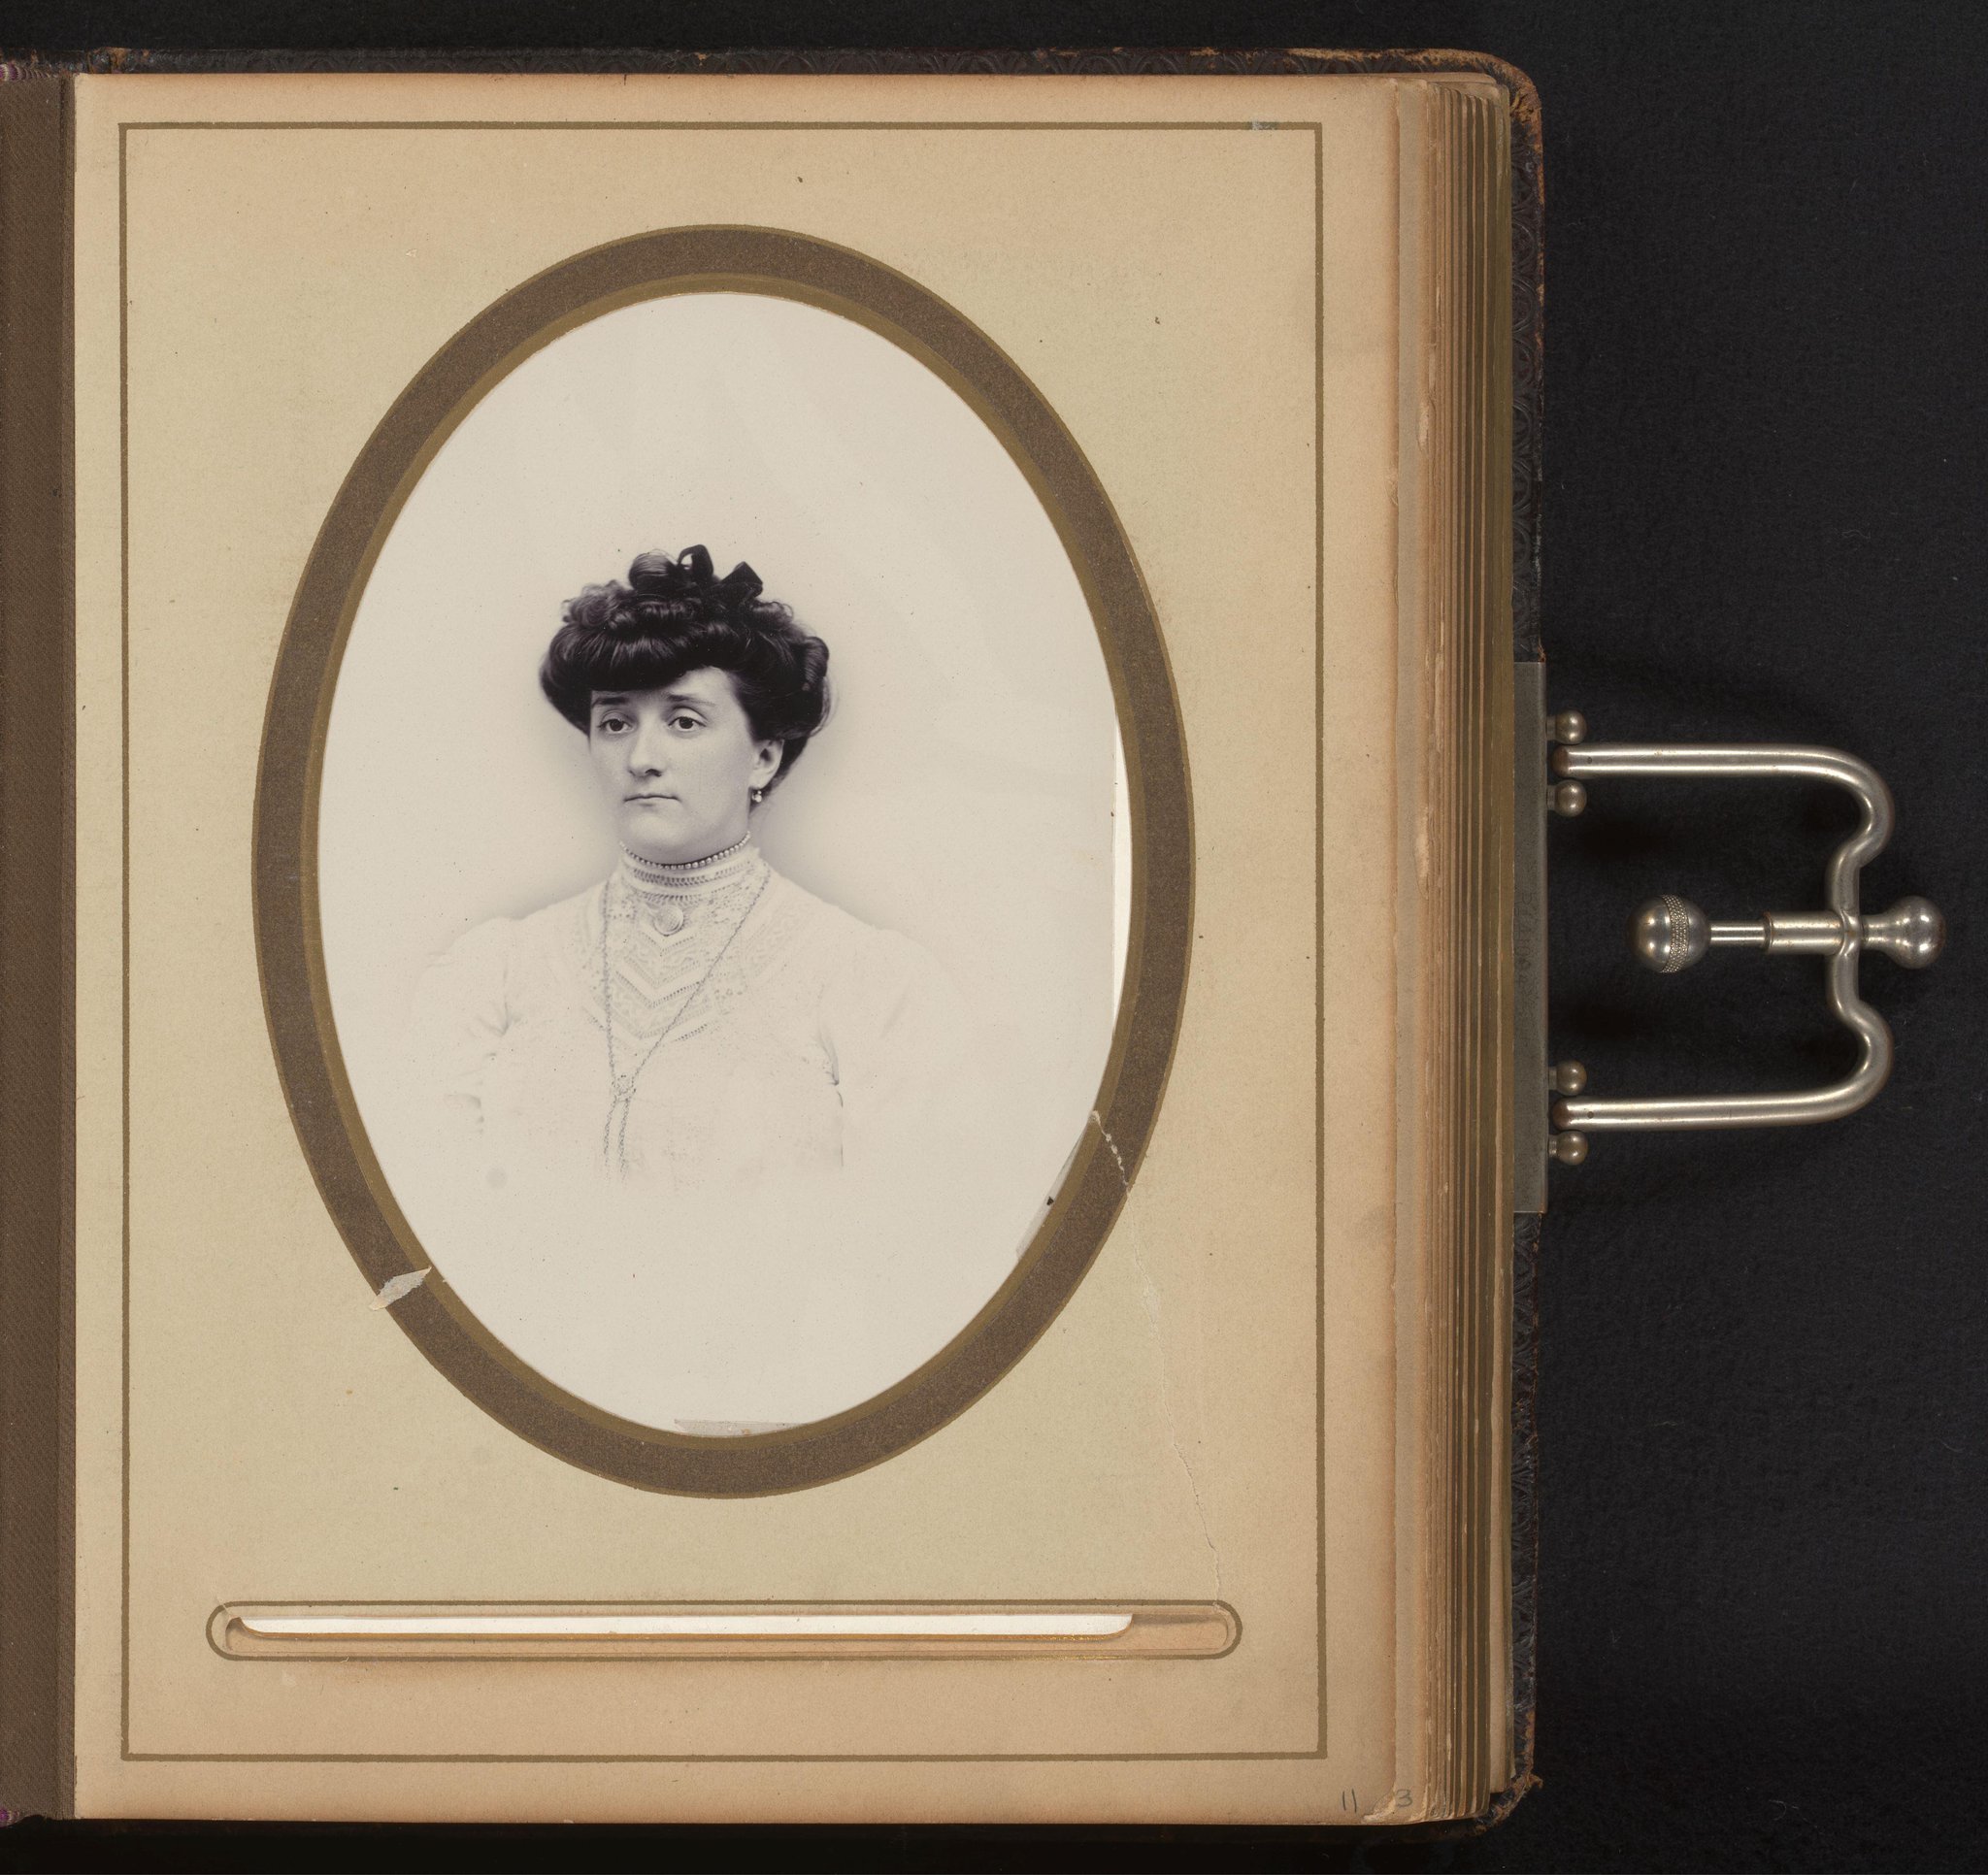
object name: cabinet photograph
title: Portret van een vrouw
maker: yu chong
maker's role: fotograaf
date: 1880-1940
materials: cardboard, photographic support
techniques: collodion silver print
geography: hanoi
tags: historical persons - bb - woman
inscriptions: inscription: ‘Yu Chong/ PEINTRE SUR IVOIRE ET AGRANDISSEMENT/ DES PHOTOGRAPHES/ 79 RUE DES PANIERS 79/ HANOÏ’